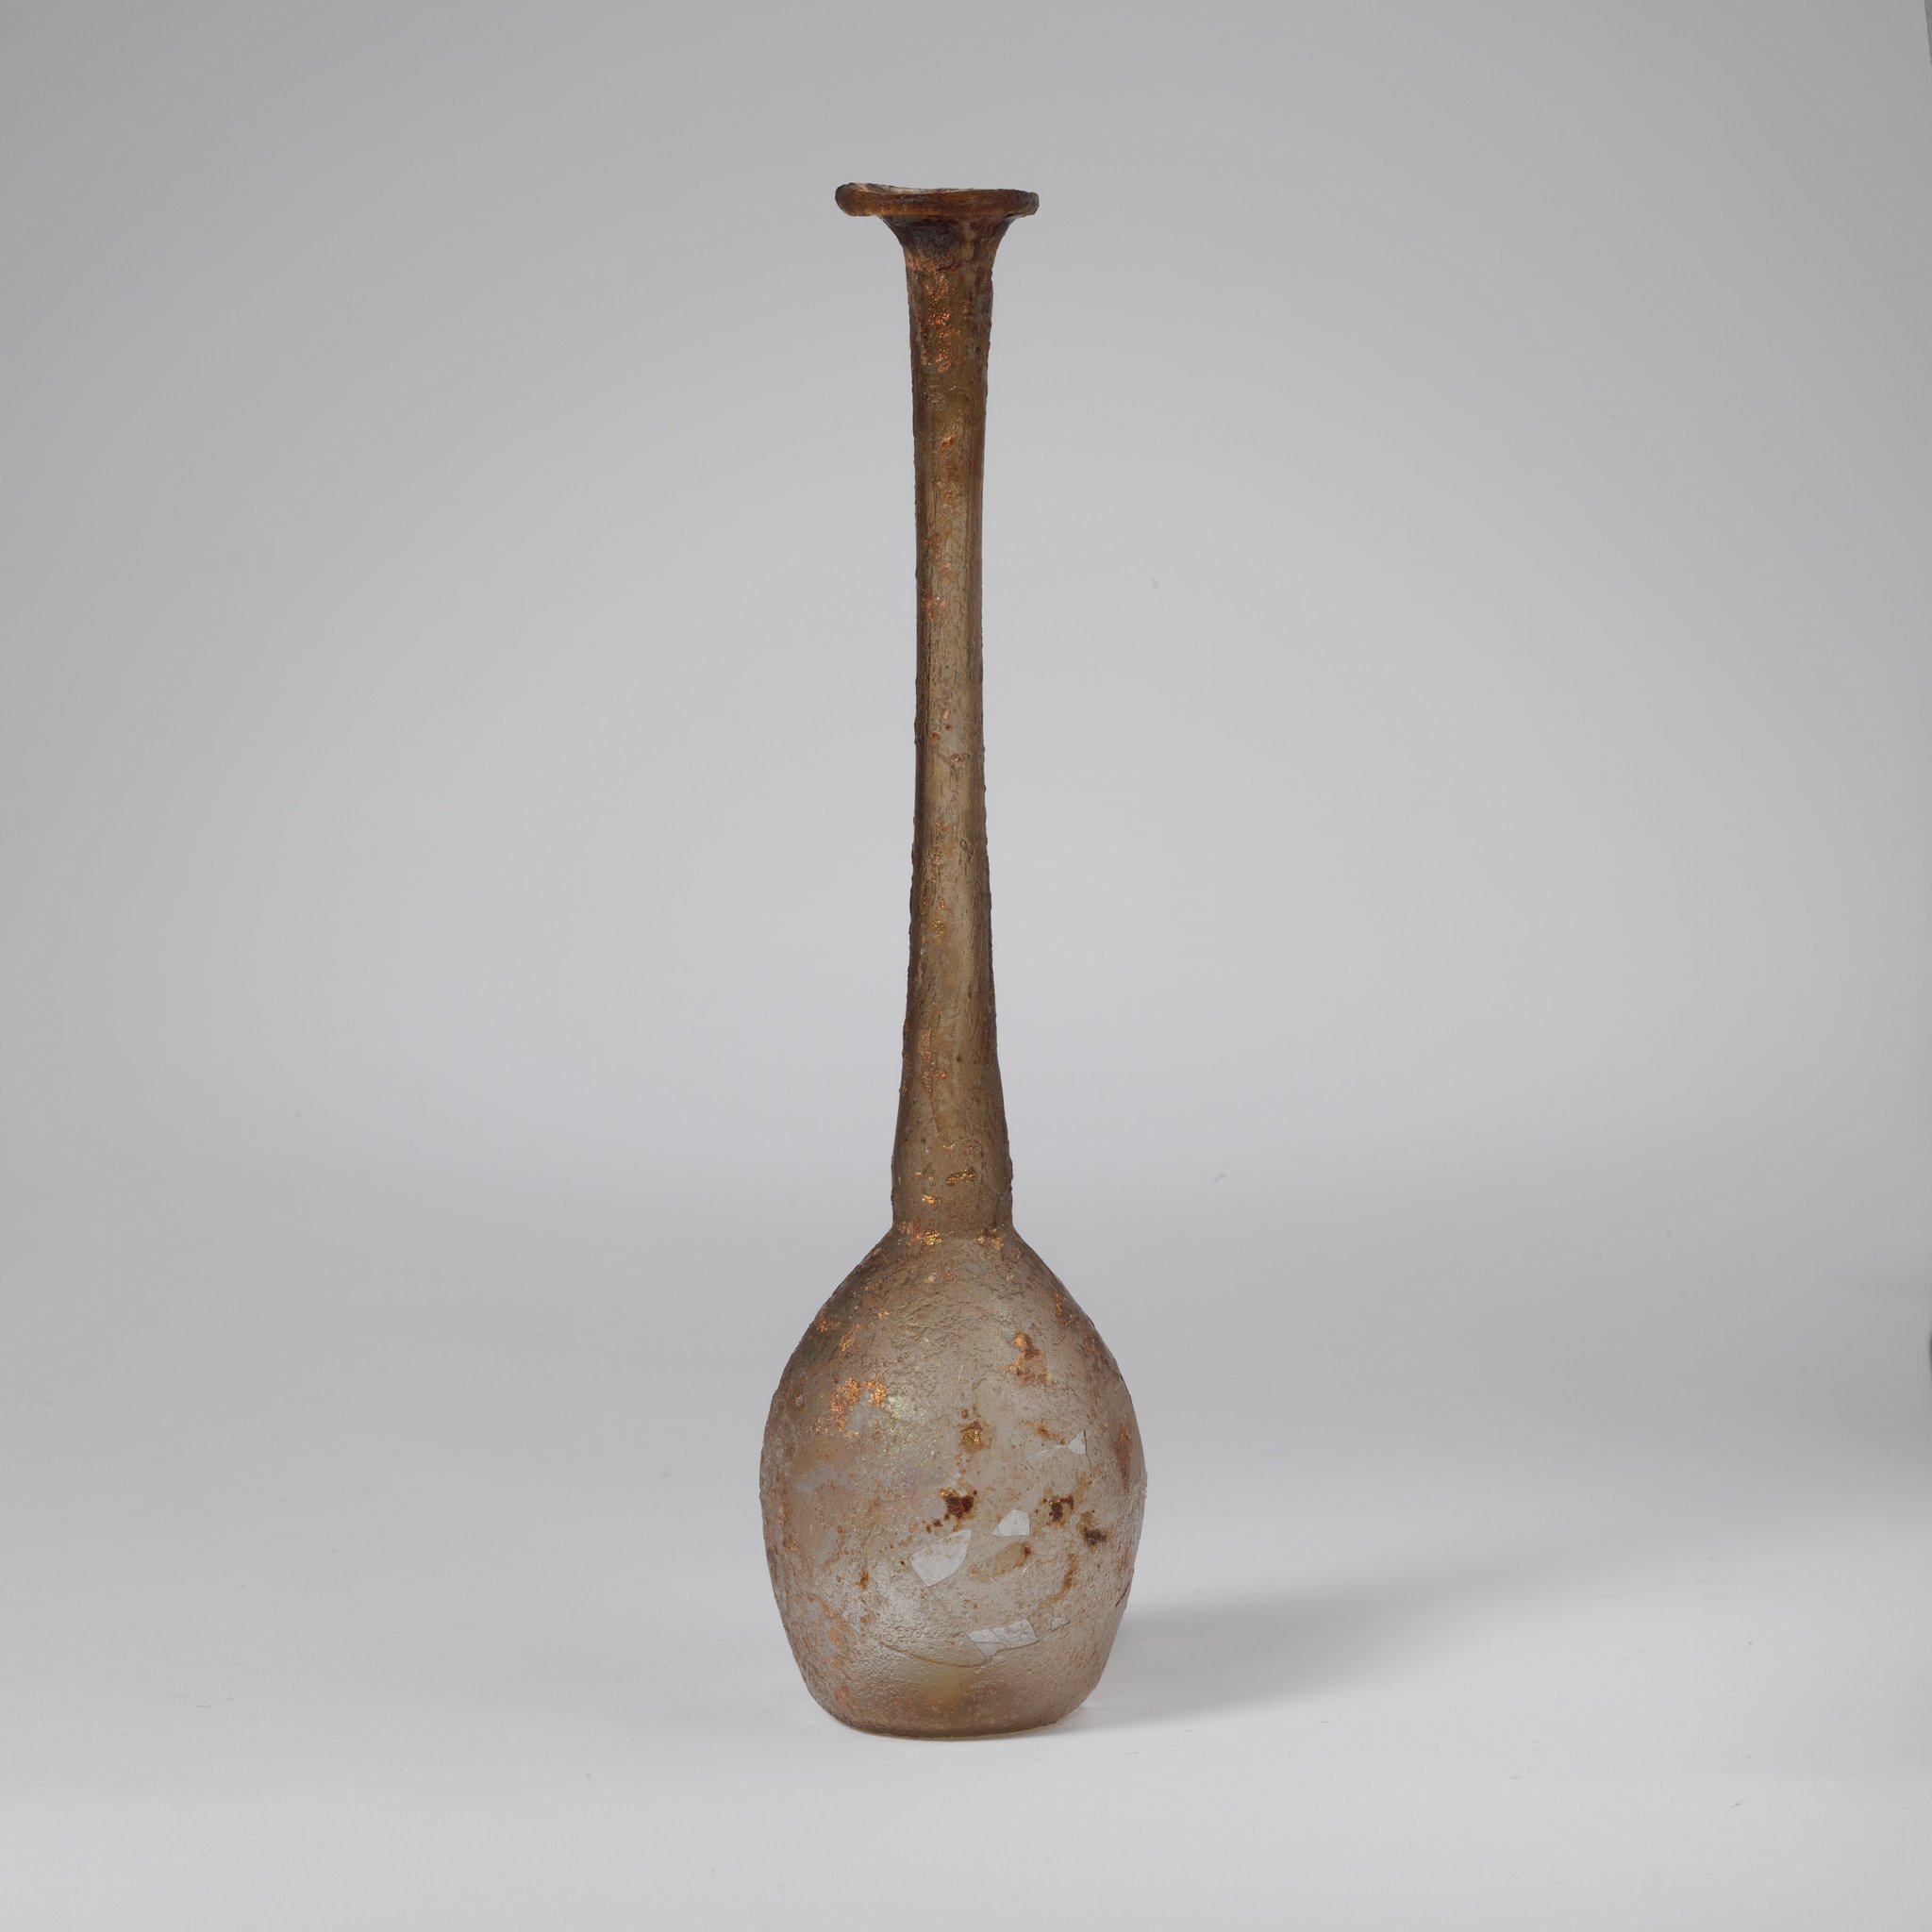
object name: bottle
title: Glass perfume bottle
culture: roman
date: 101-300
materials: glass